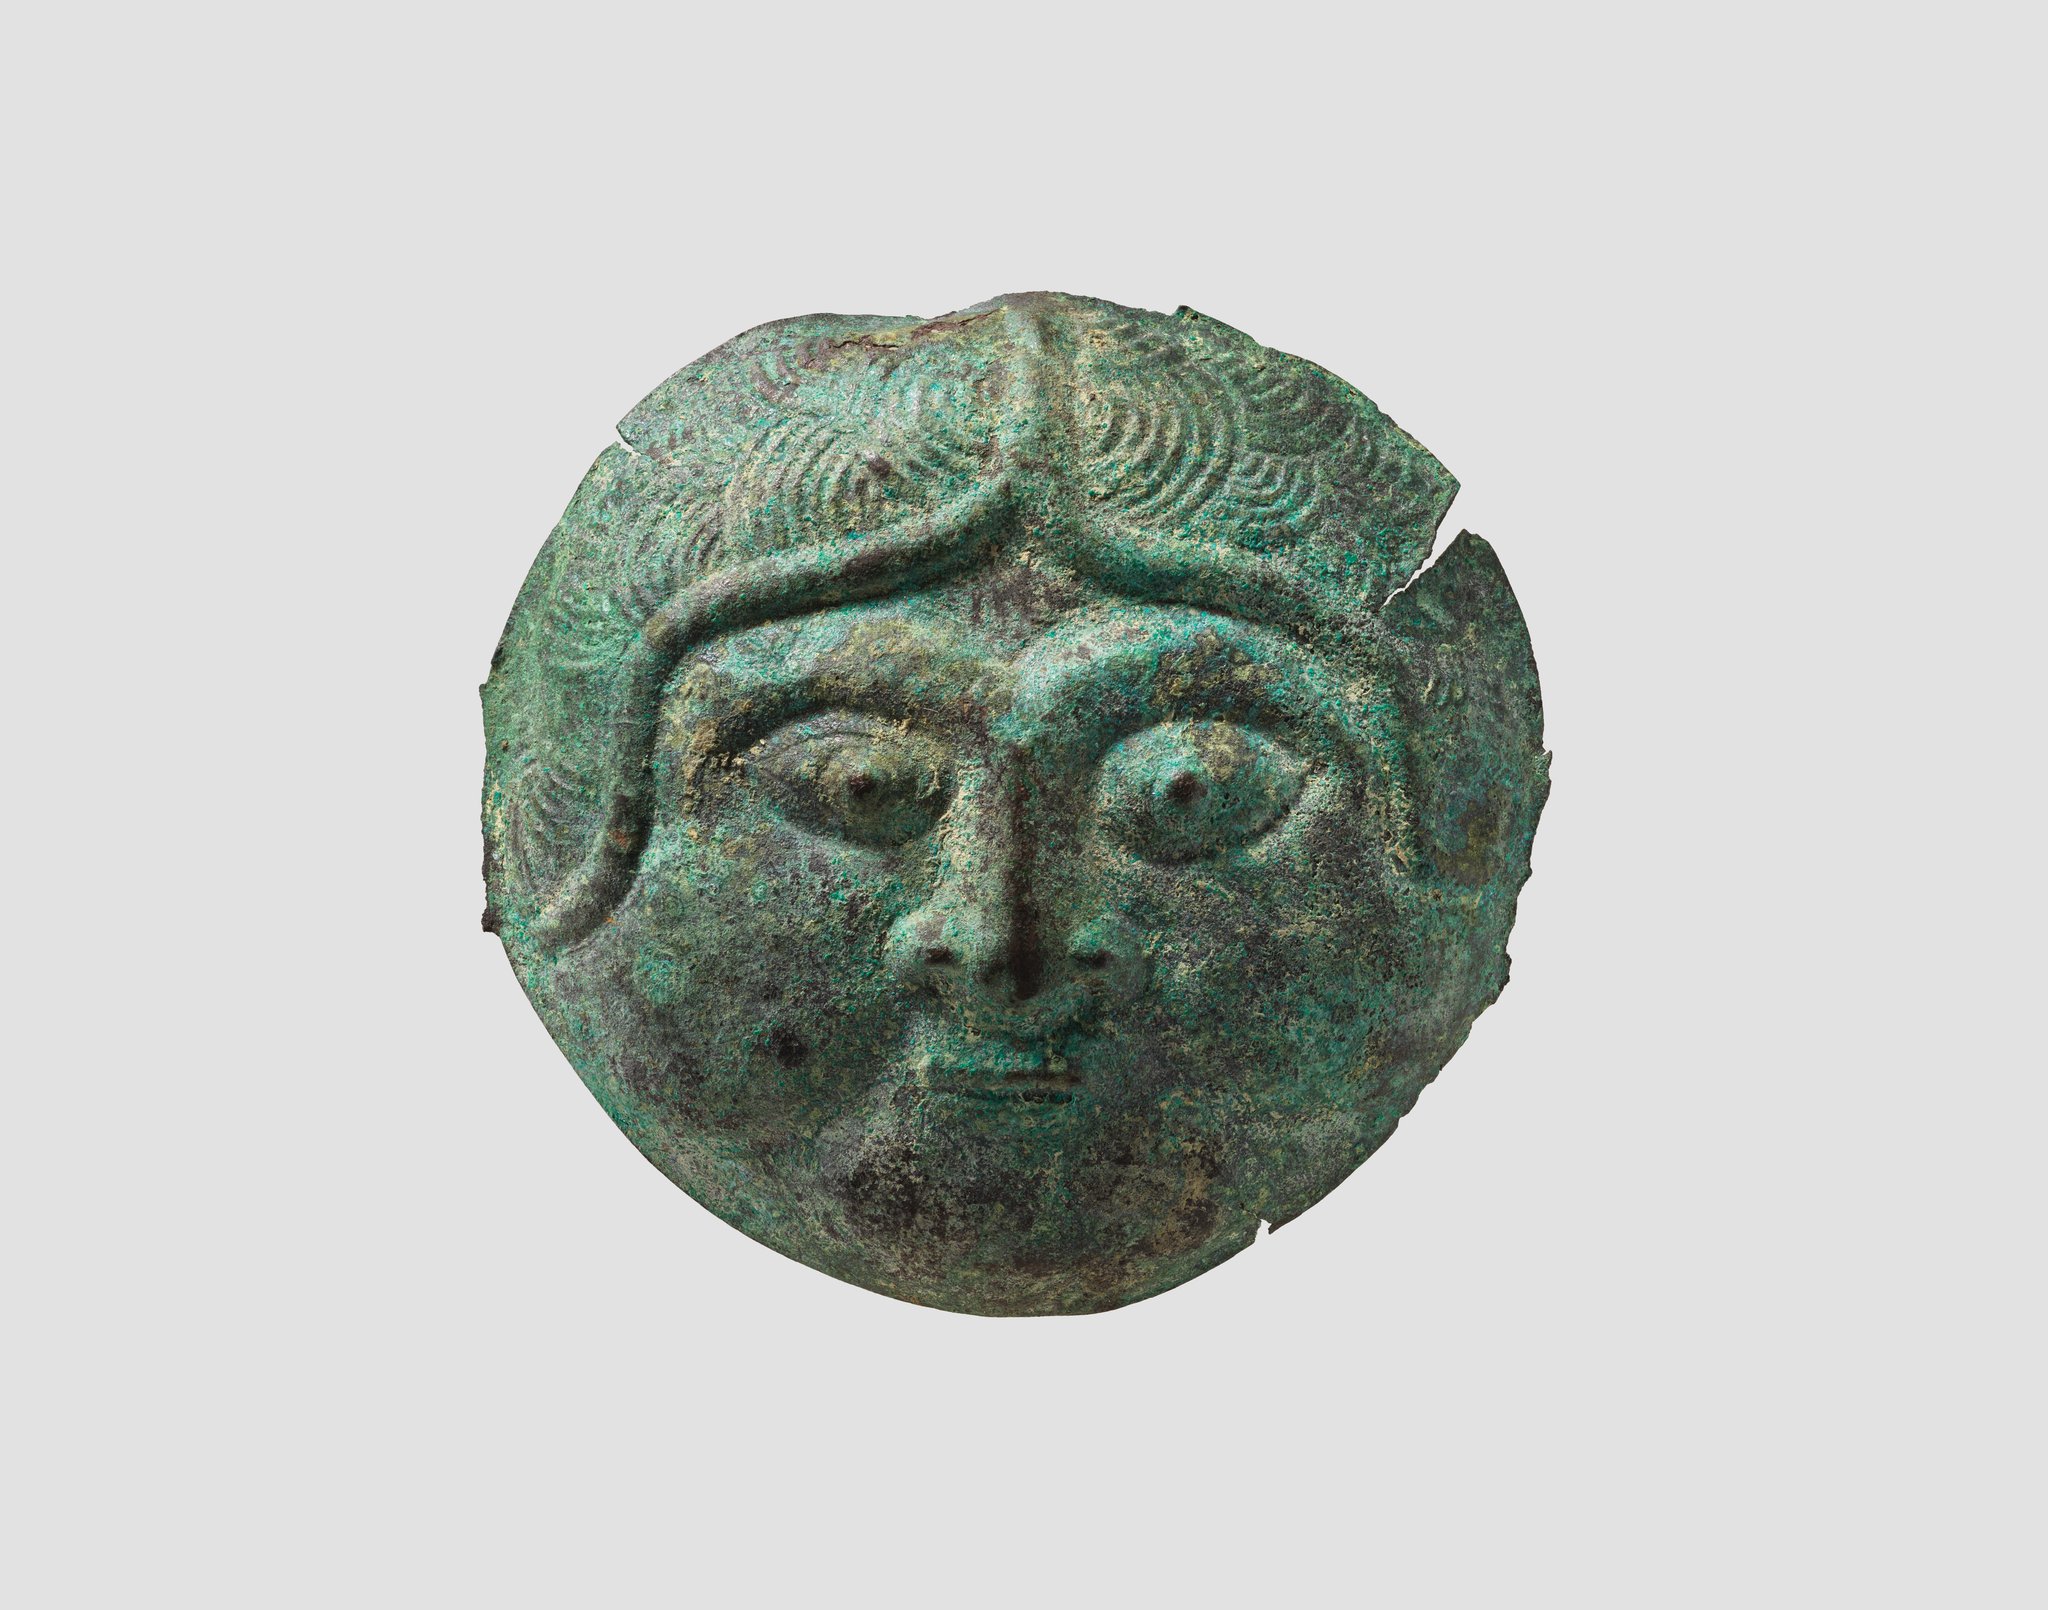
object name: disc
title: Disc plaque or boss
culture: iranian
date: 800-601 BCE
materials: bronze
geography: iran, probably from luristan